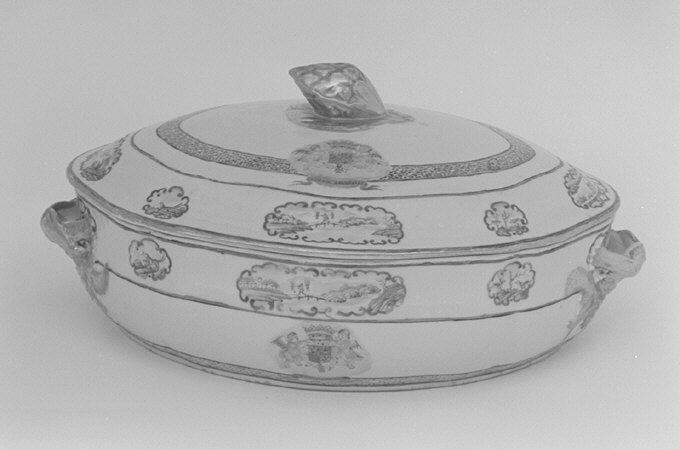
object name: dish with cover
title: Dish with cover (part of a service)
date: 1800-1805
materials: hard paste porcelain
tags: coat of arms